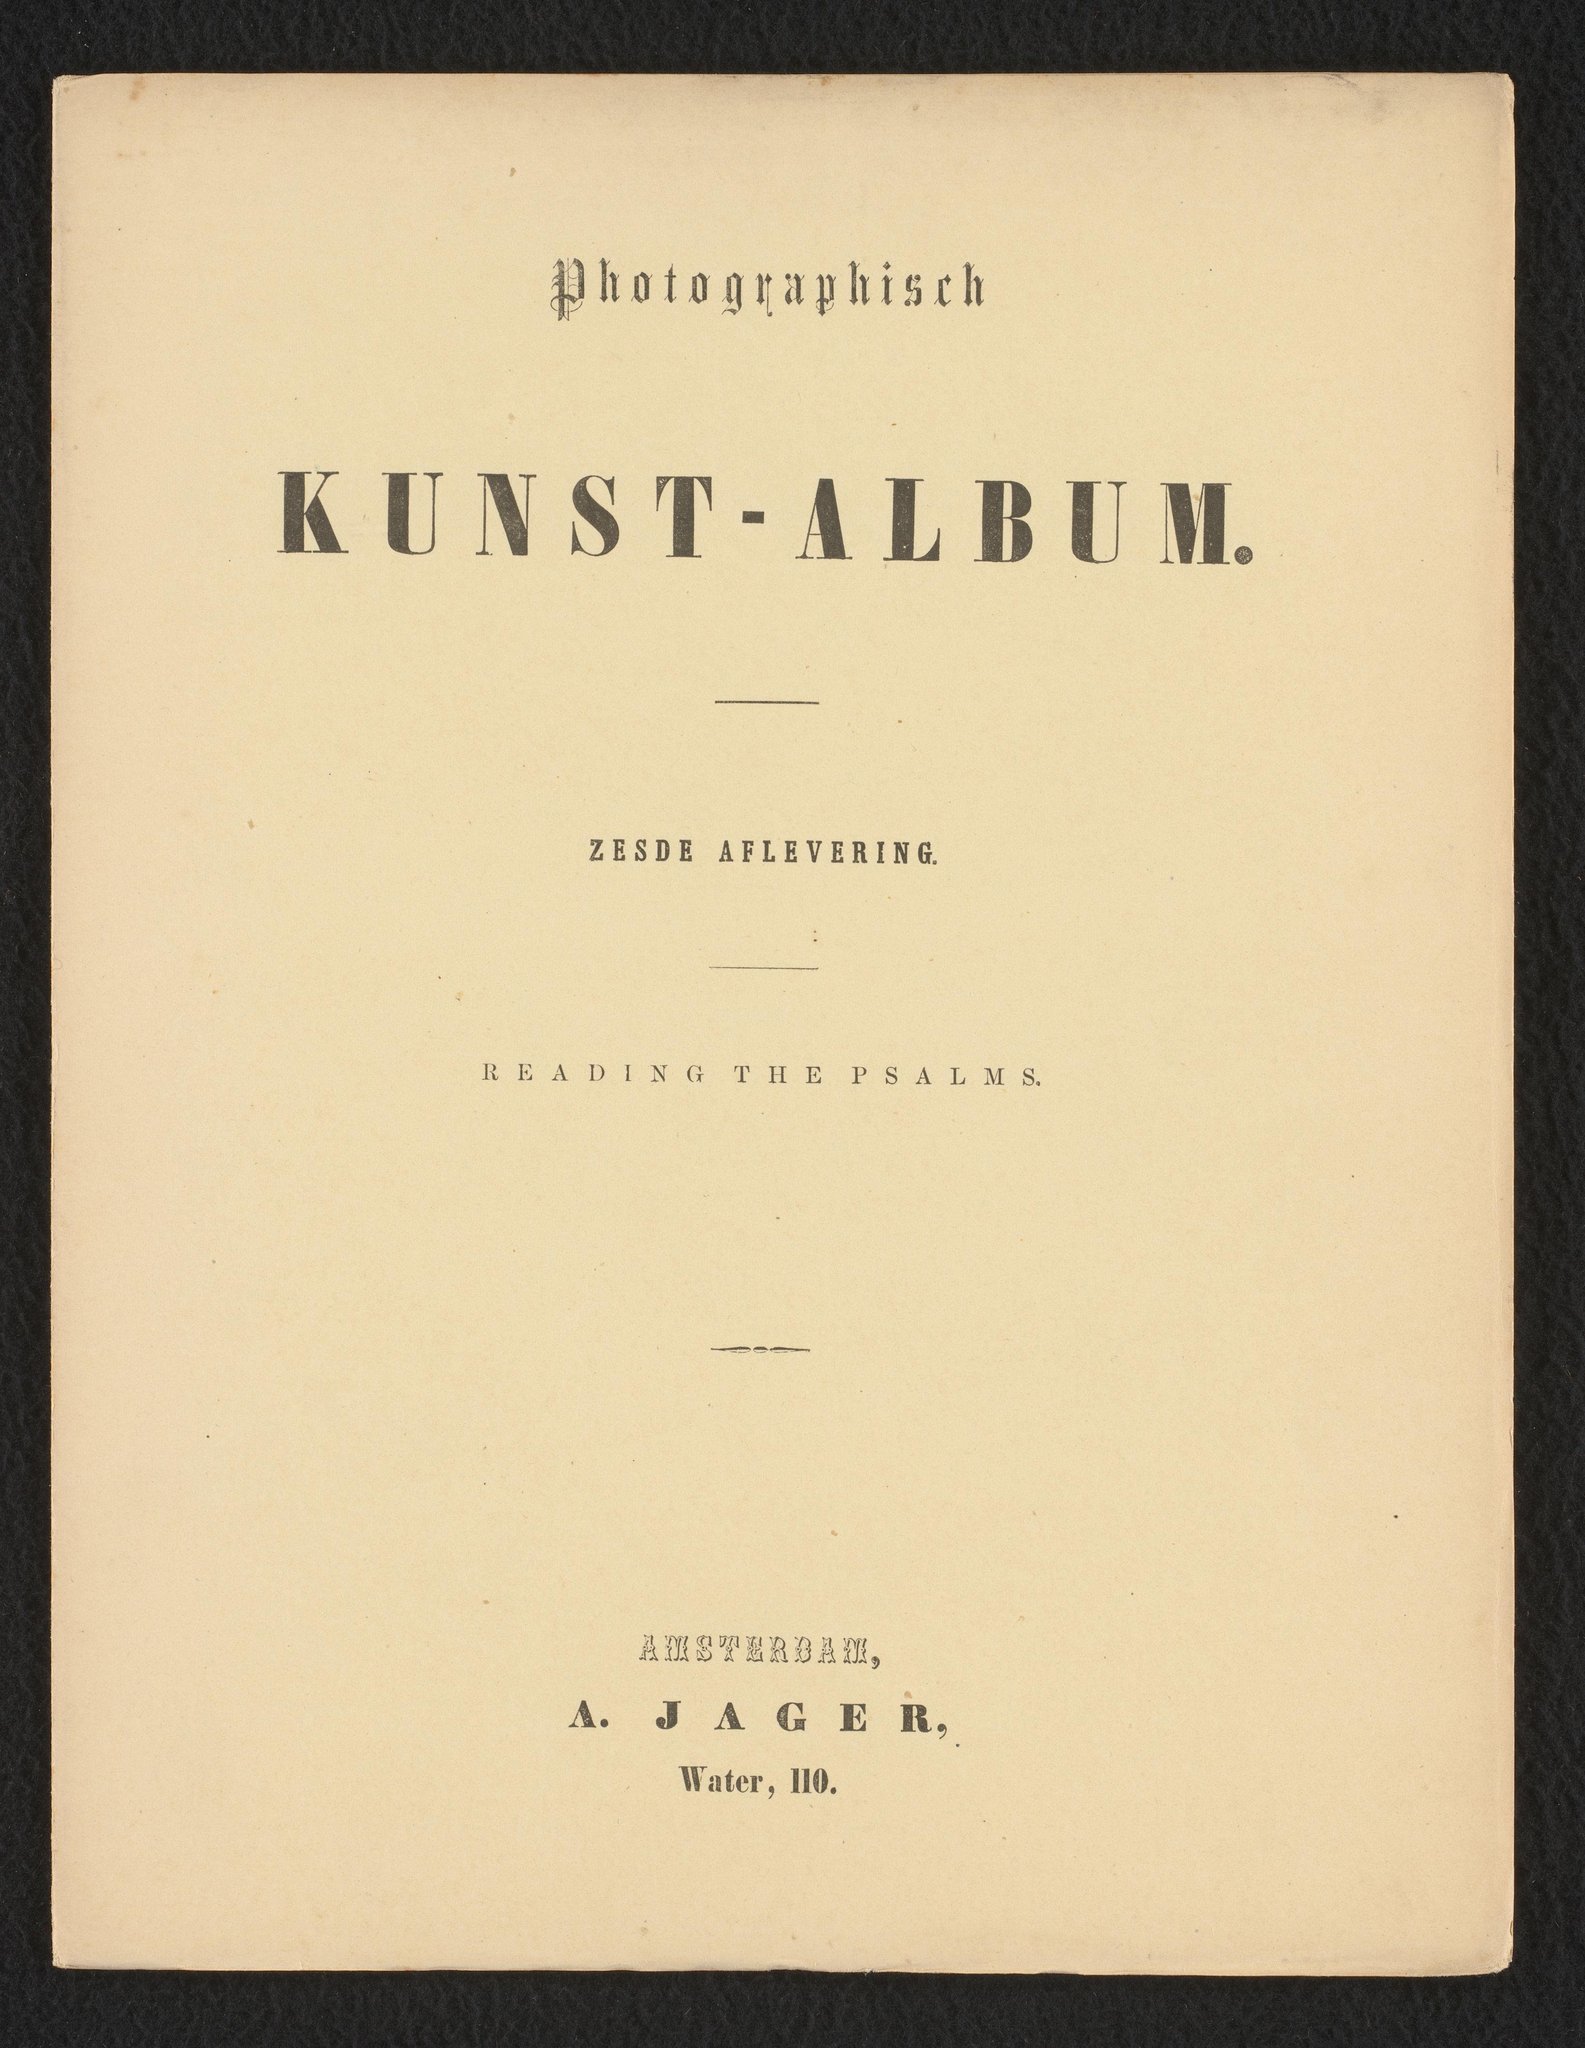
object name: wrapper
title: Omslag voor een fotoreproductie van het schilderij Reading the Psalms naar W.C.T. Dorson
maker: andries jager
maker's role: publisher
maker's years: 1825-1905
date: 1860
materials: paper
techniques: printing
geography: amsterdam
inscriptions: inscription: ‘READING THE PSALMS./ NAAR EENE SCHILDERIJ/ VAN/ W. C. T. DORSON.’, address: ‘AMSTERDAM,/ A. JAGER,/ Water, 110.’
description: Deze omslag maakt deel uit van een omslag met twaalf fotoreproducties.